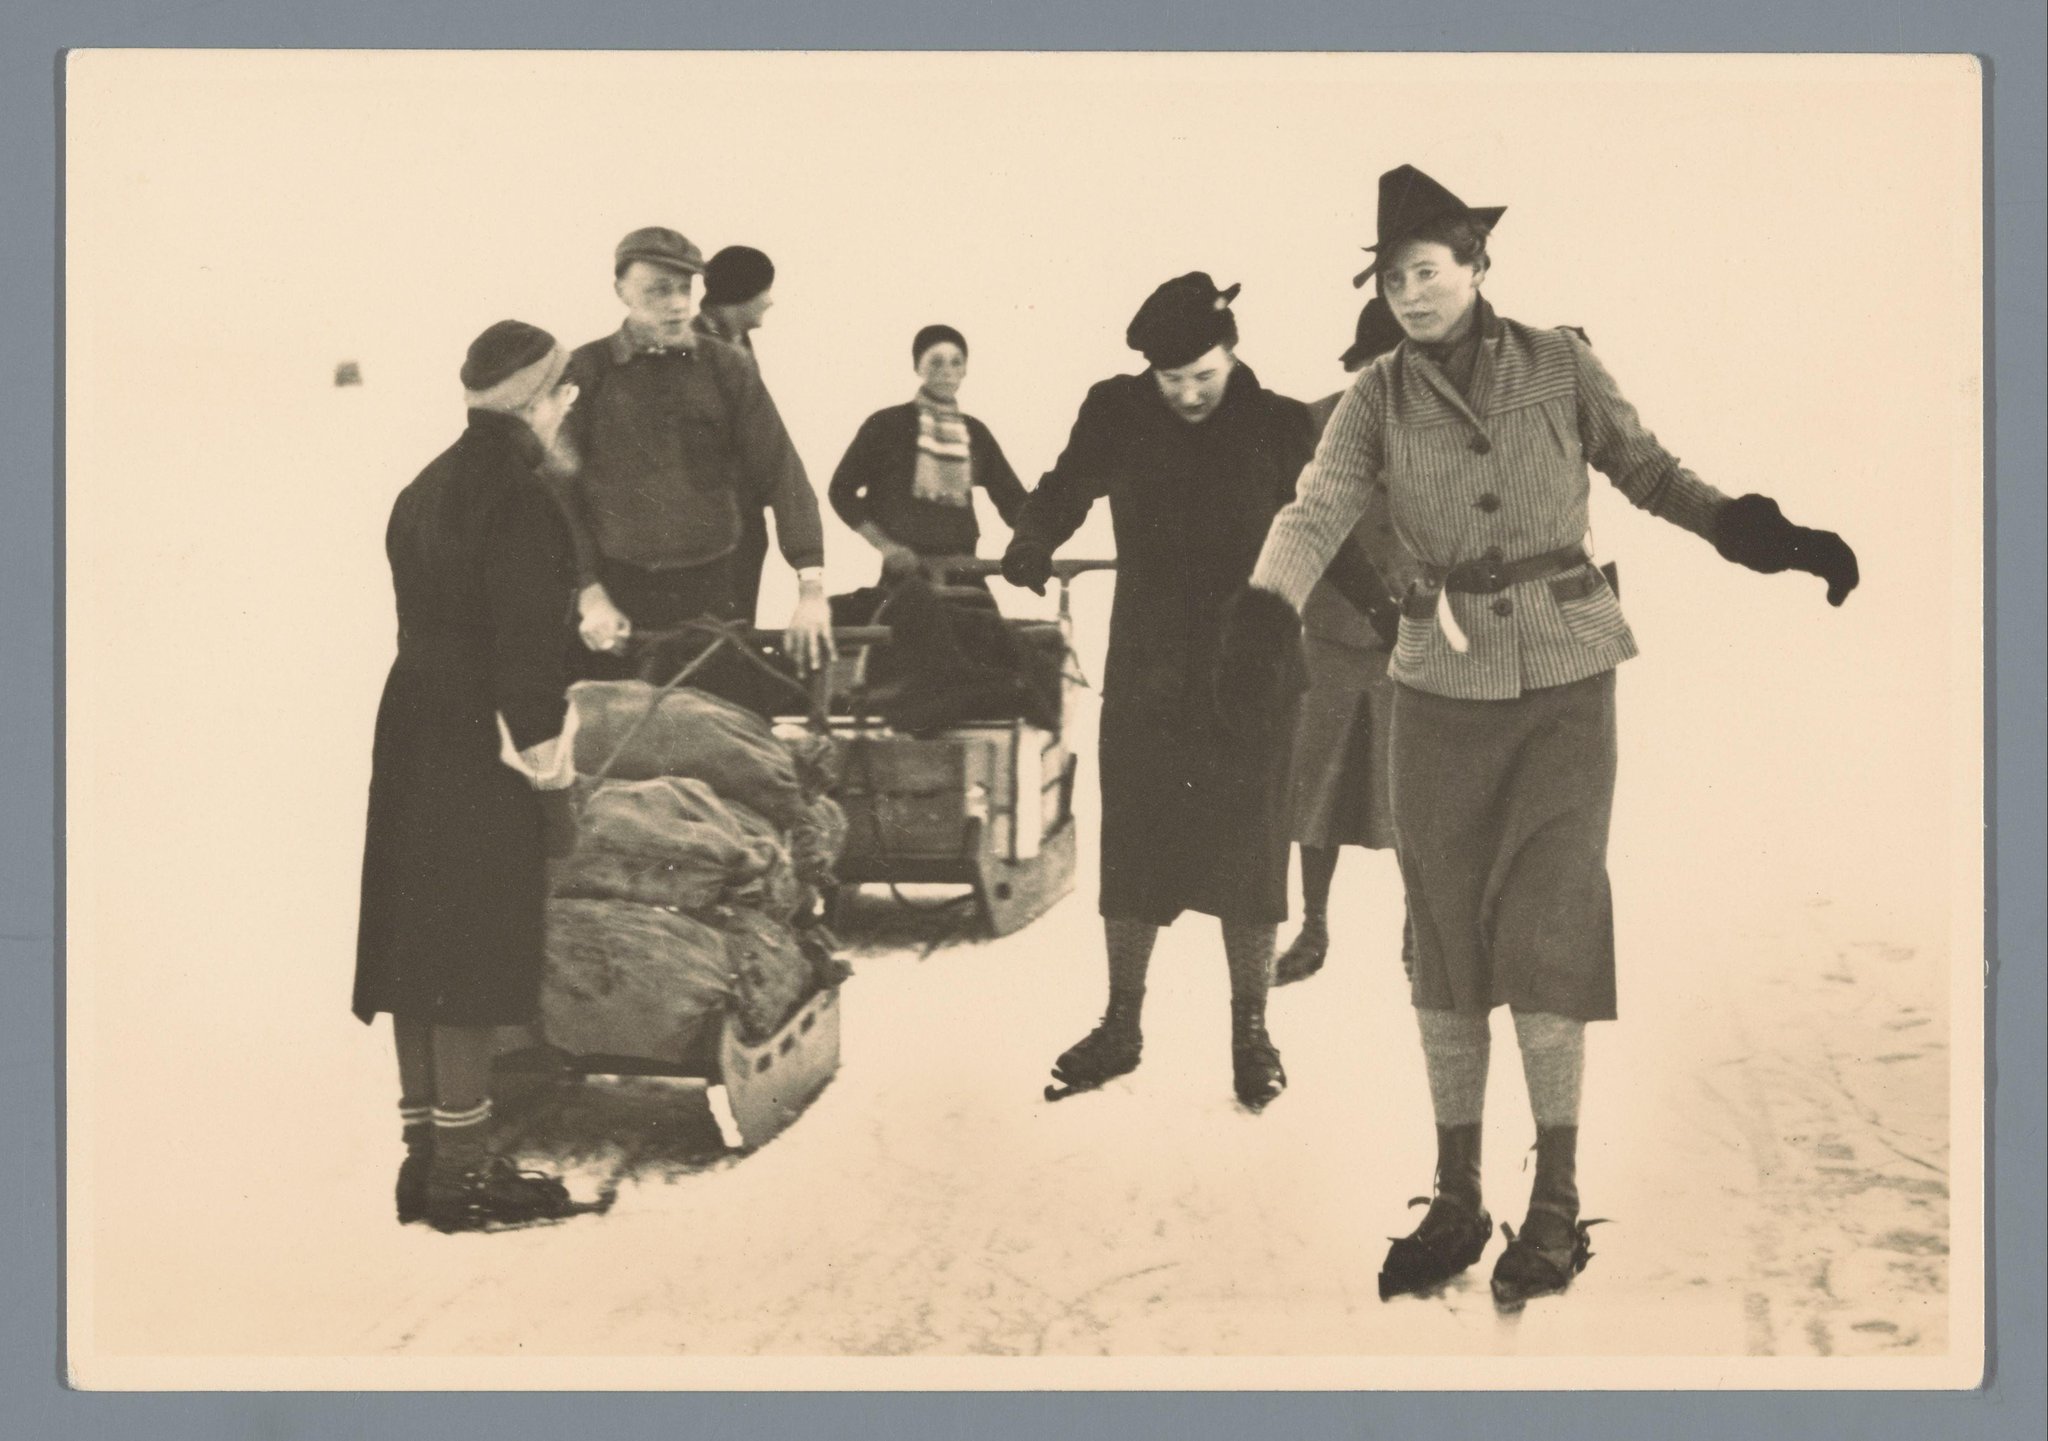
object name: photograph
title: Gouwzee, 23 Januari 1940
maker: Anonymous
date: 1940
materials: photographic support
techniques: gelatin silver print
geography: gouwzee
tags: skates (winter sports)